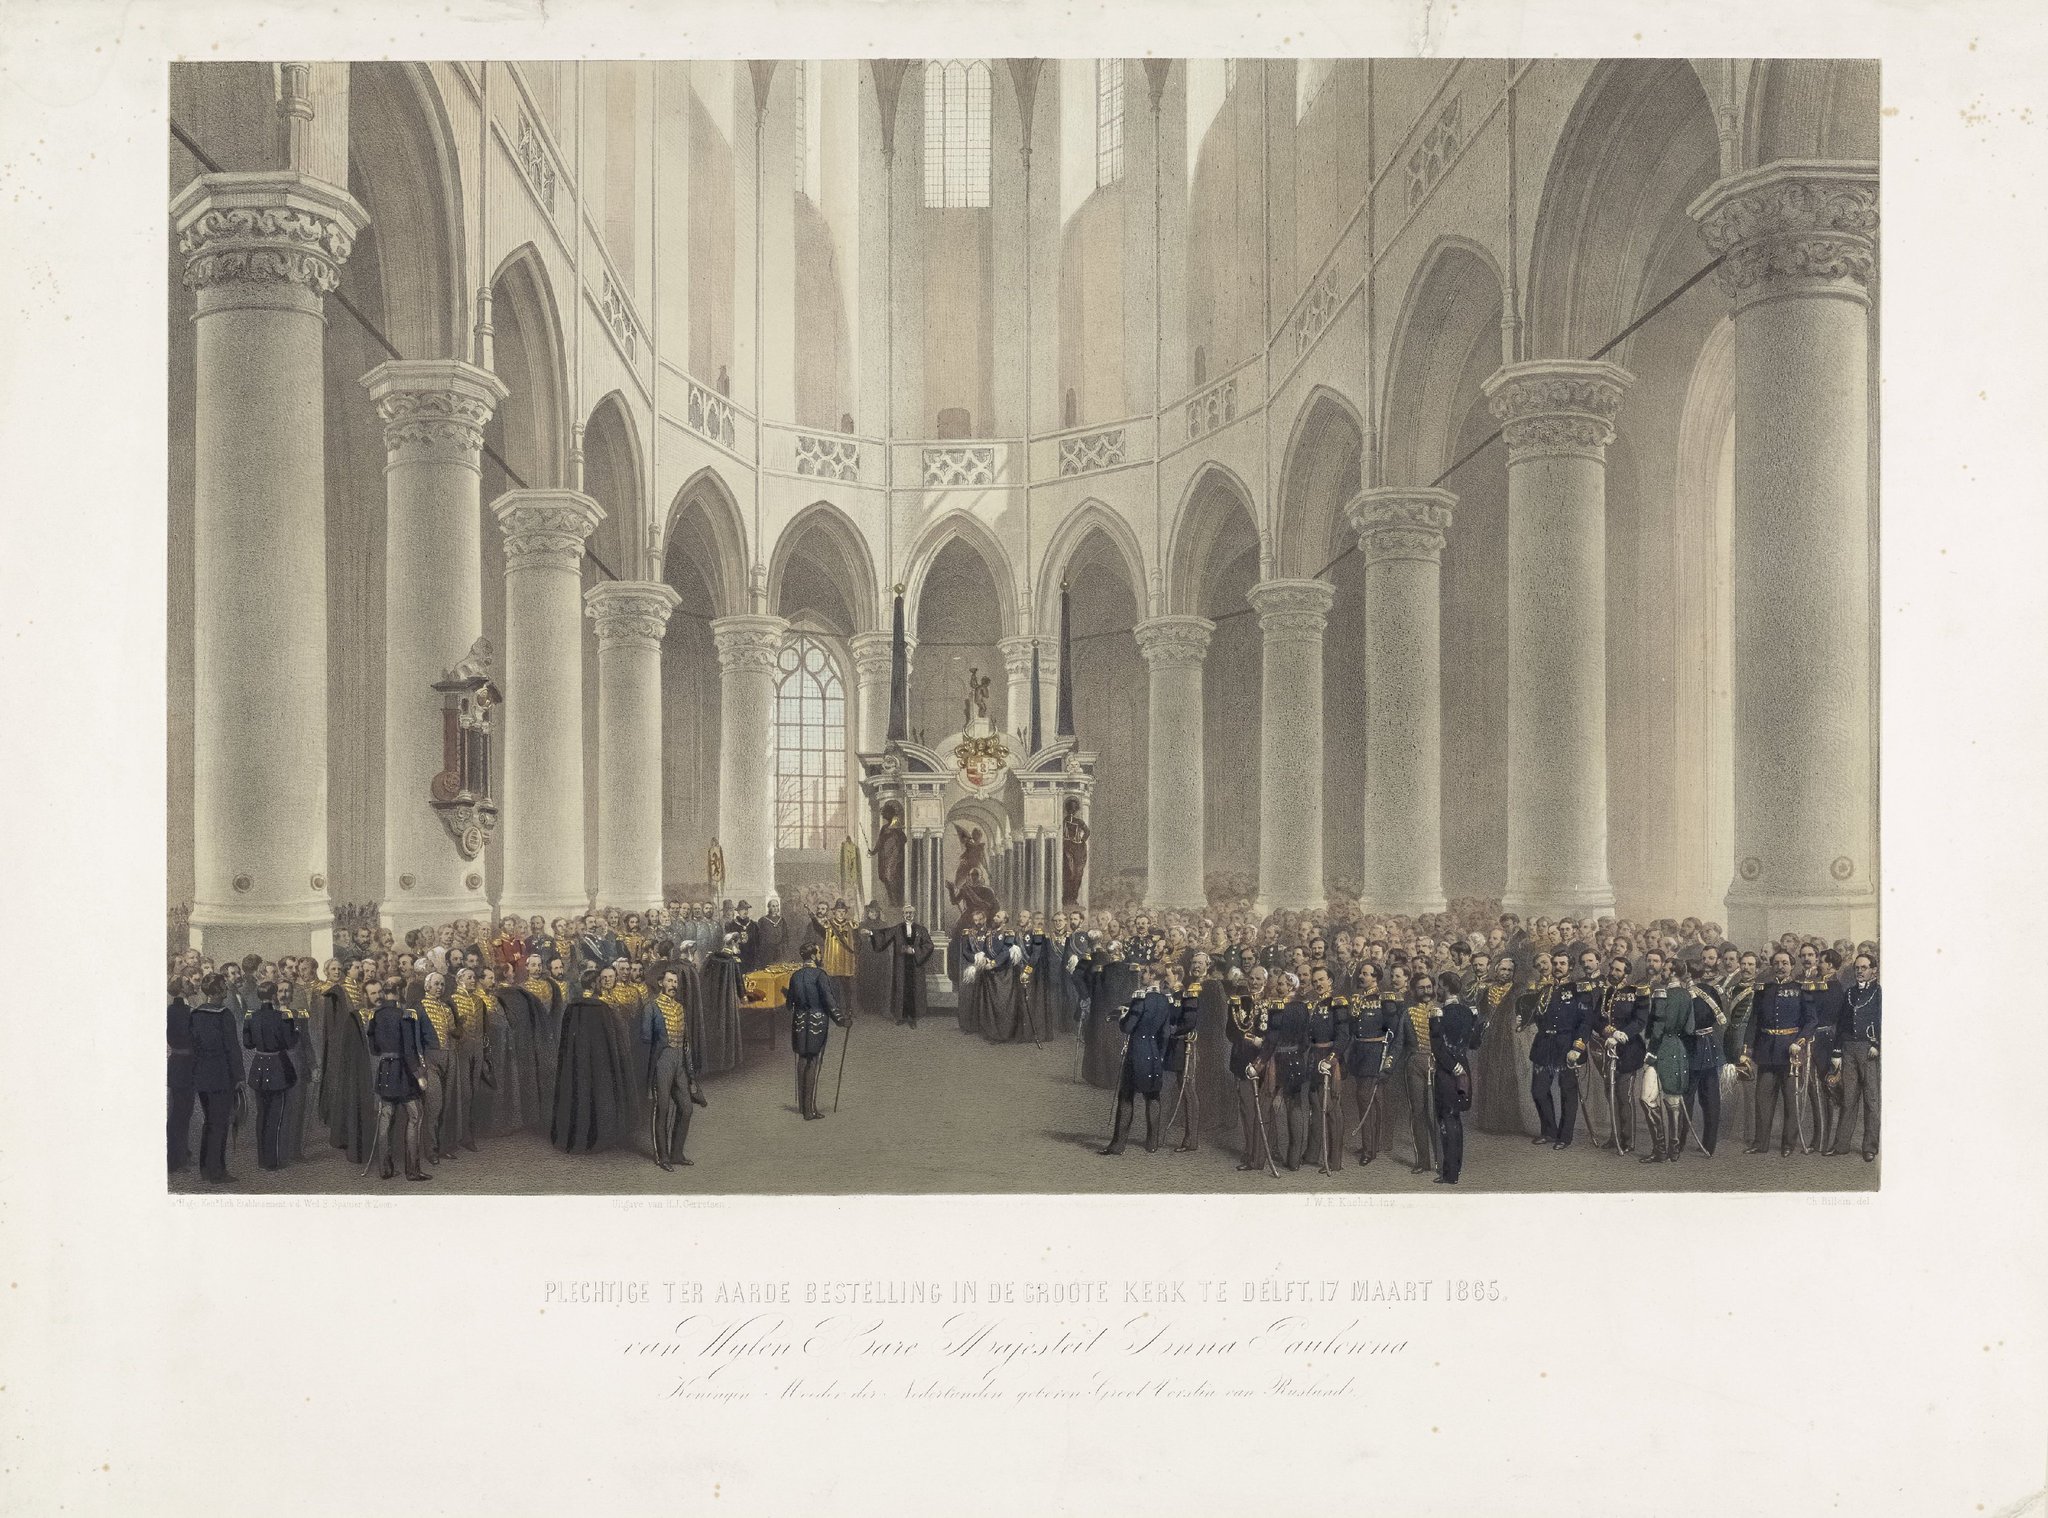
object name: print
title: Plechtige ter aarde bestelling in de Groote Kerk te Delft, 17 Maart 1865, van Wijlen Hare Majesteit Anna Paulowna Koningin-Moeder der Nederlanden geboren Groot Vorstin van Rusland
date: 1865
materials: paper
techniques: lithograph, hand coloring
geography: netherlands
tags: anna paulowna romanowa, brussels, willem iii (koning der nederlanden), interior of church, funerary ceremonial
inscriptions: collector's mark: Lugt 2228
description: Begrafenisceremonie voor wijlen koningin Anna Paulowna, overleden op 1 maart, in de Nieuwe Kerk te Delft op 17 maart 1865. Gezicht in de kerk met een groot gezelschap van genodigden, centraal koning Willem III met de prinsen staande voor het praalgraf van Willem van Oranje.